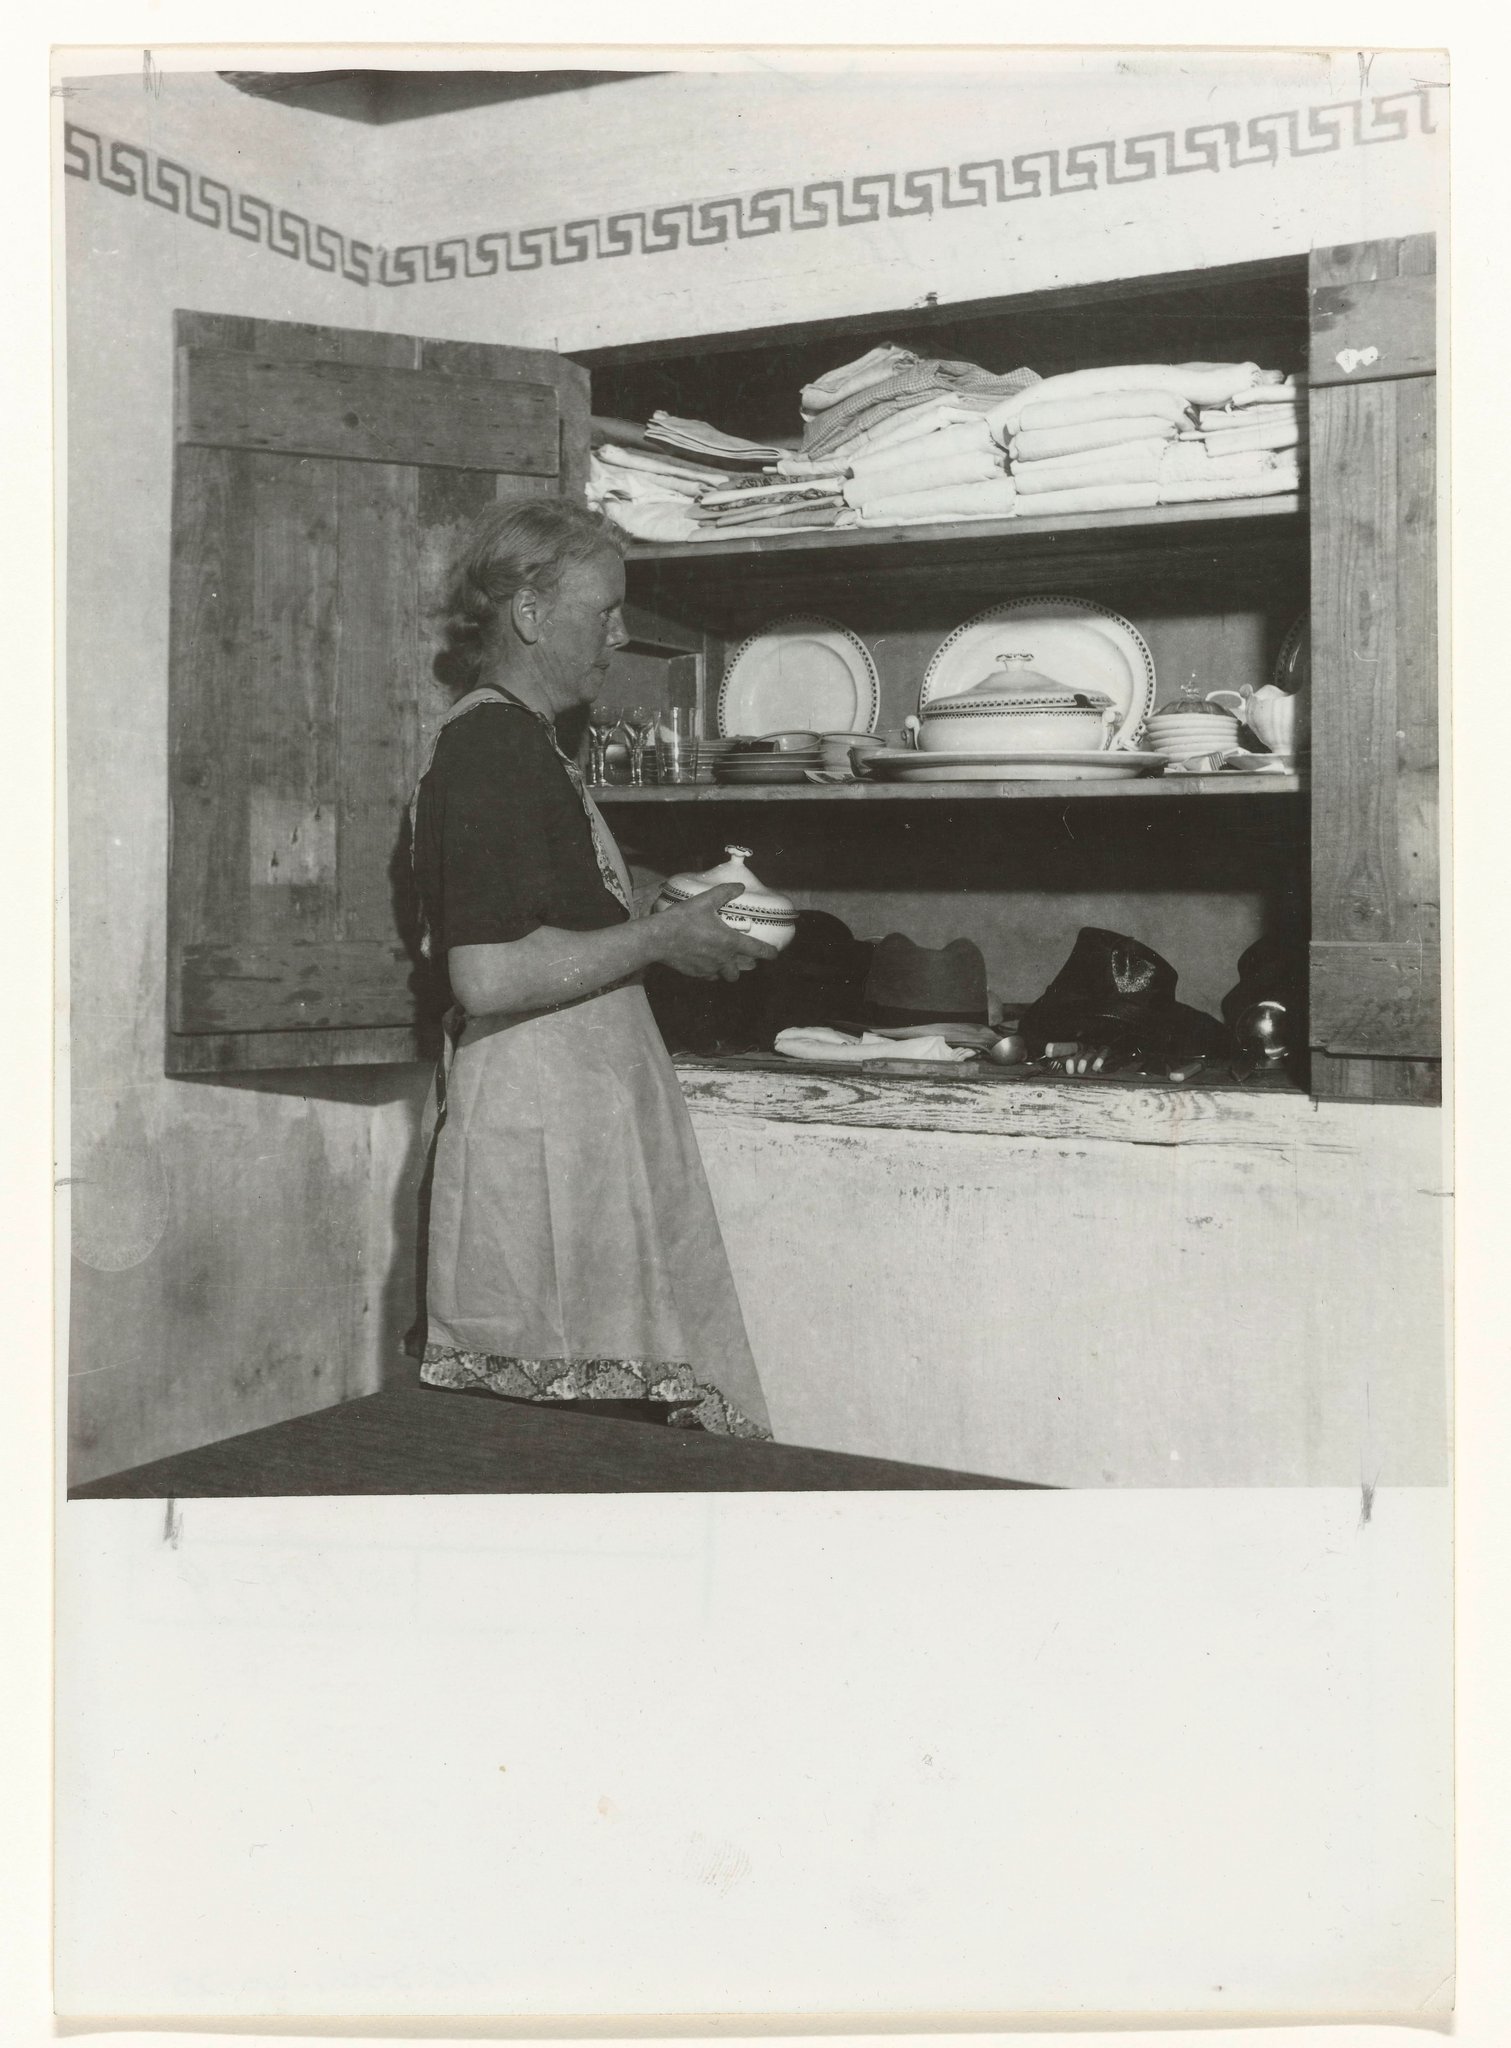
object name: documentary photograph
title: Vrouw bij een kast met serviesgoed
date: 1945-1947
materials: photographic support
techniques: photography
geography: netherlands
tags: netherlands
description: Een vrouw staat, met een schaal in haar handen, voor een kast met serviesgoed en linnen.